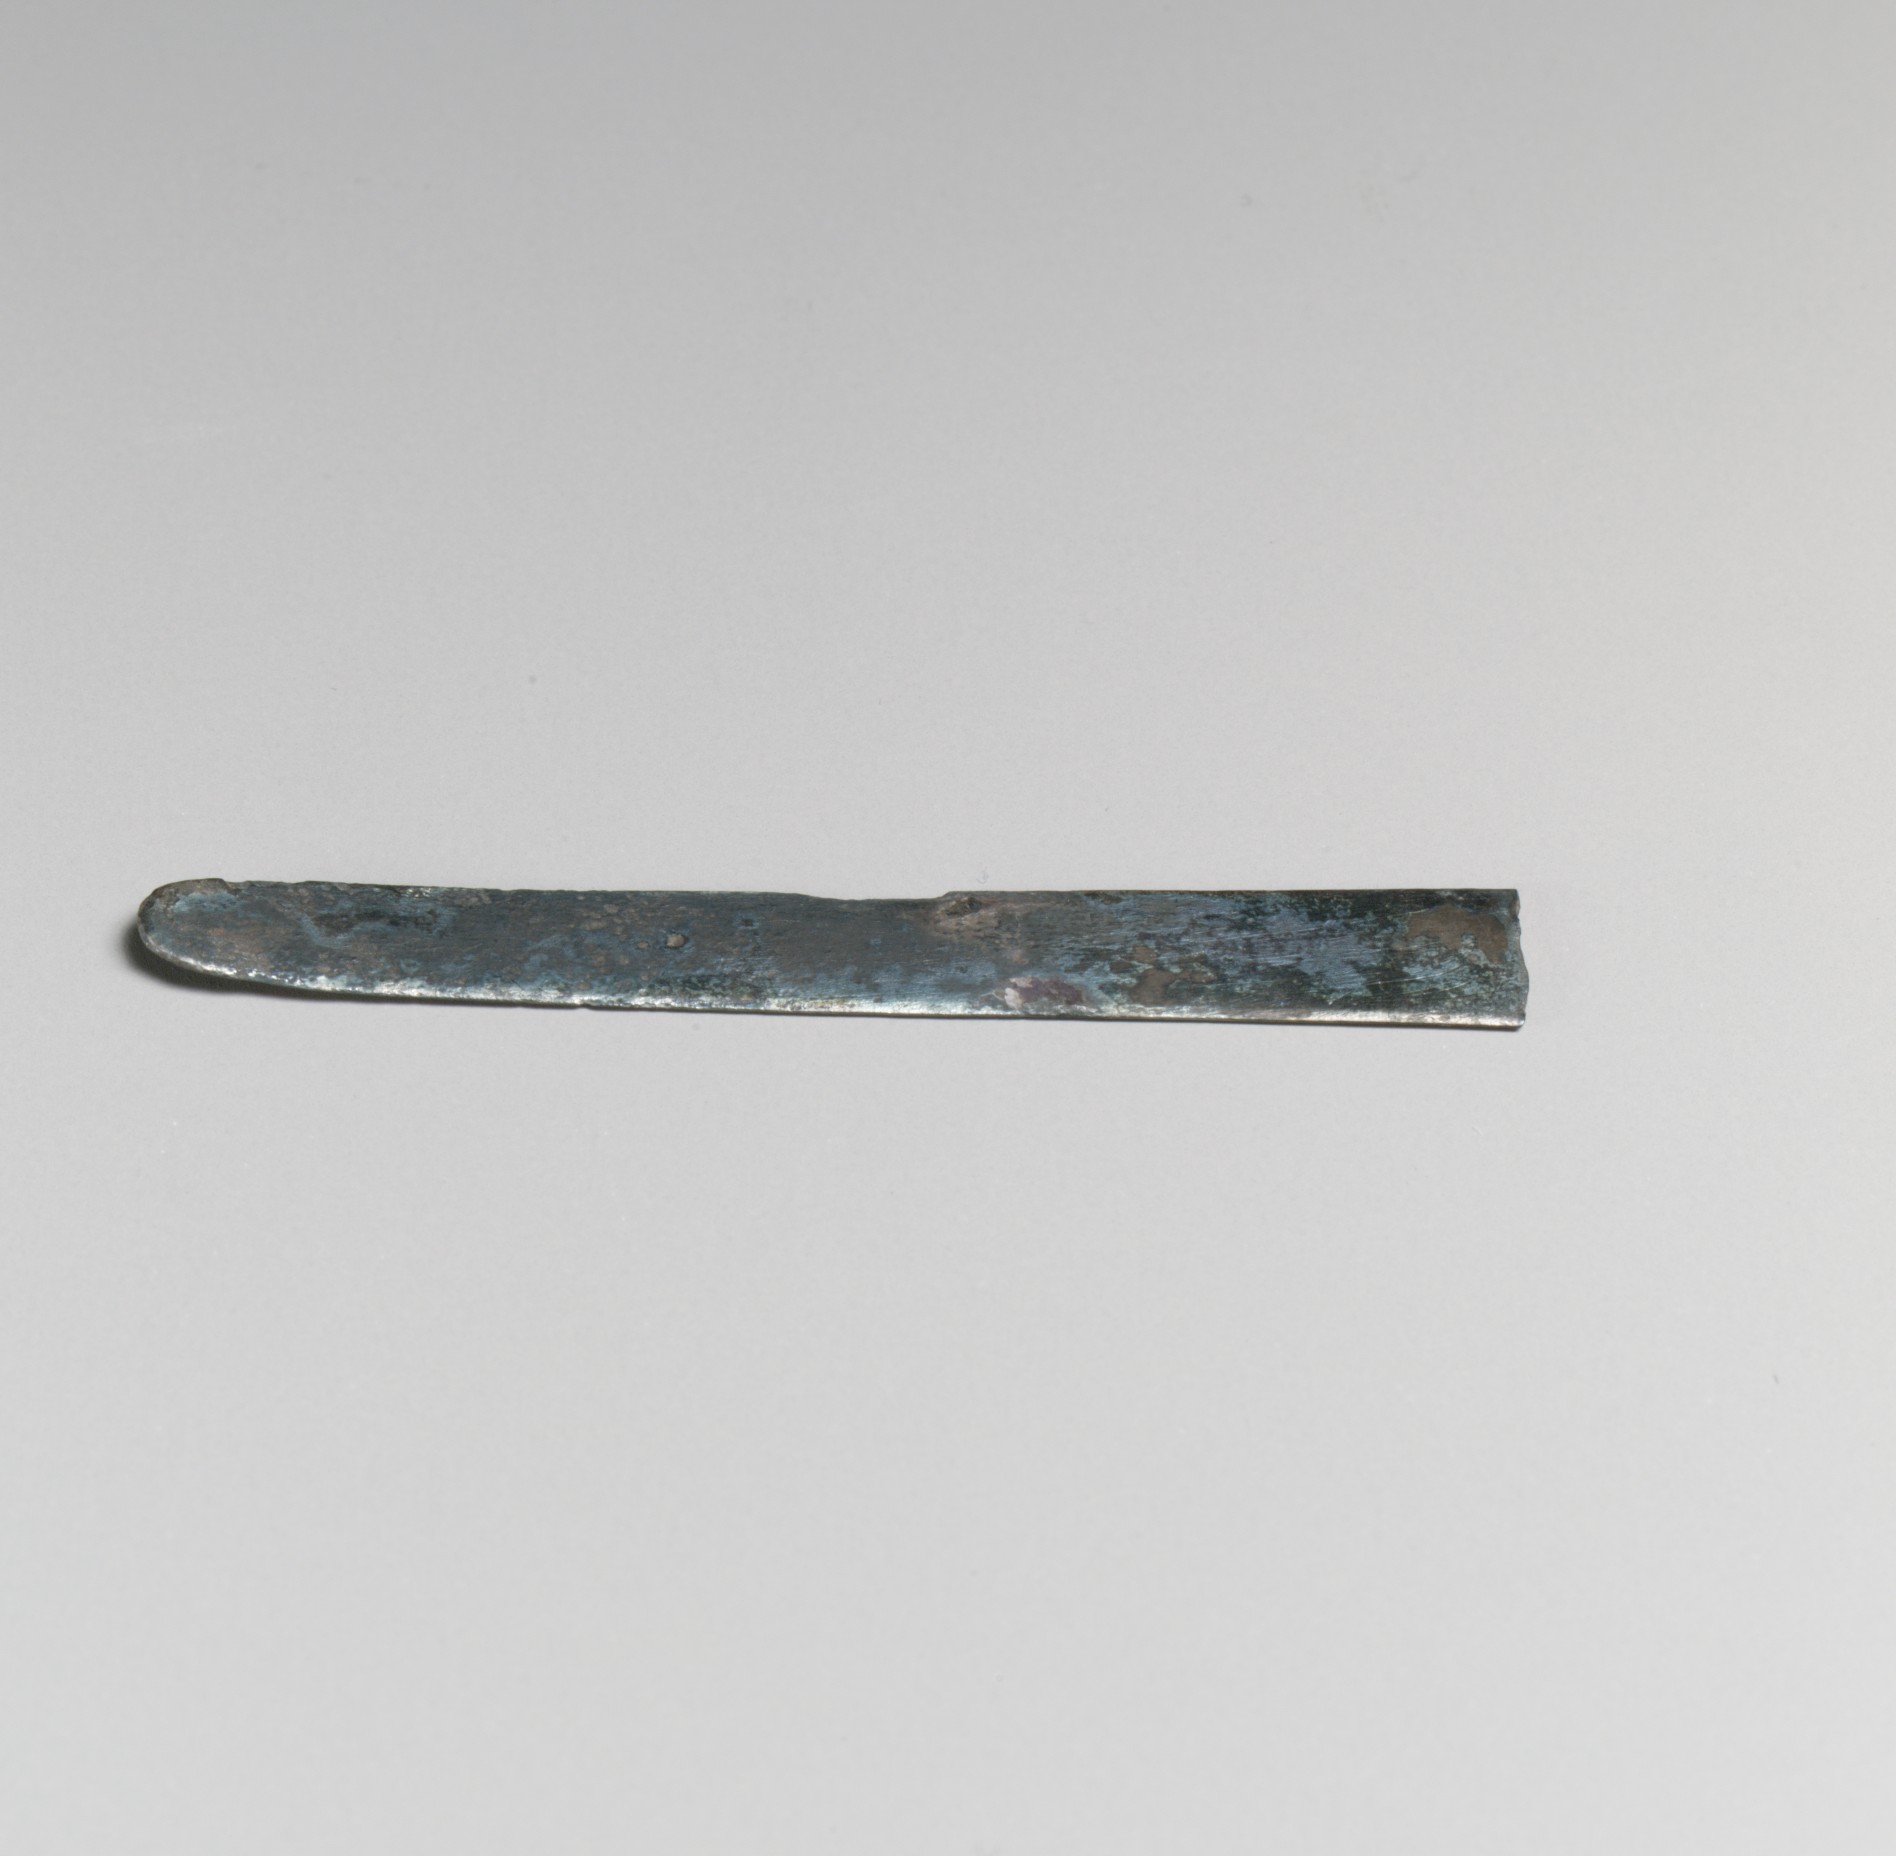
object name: knife fragment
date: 7000 BCE-330 CE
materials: bronze